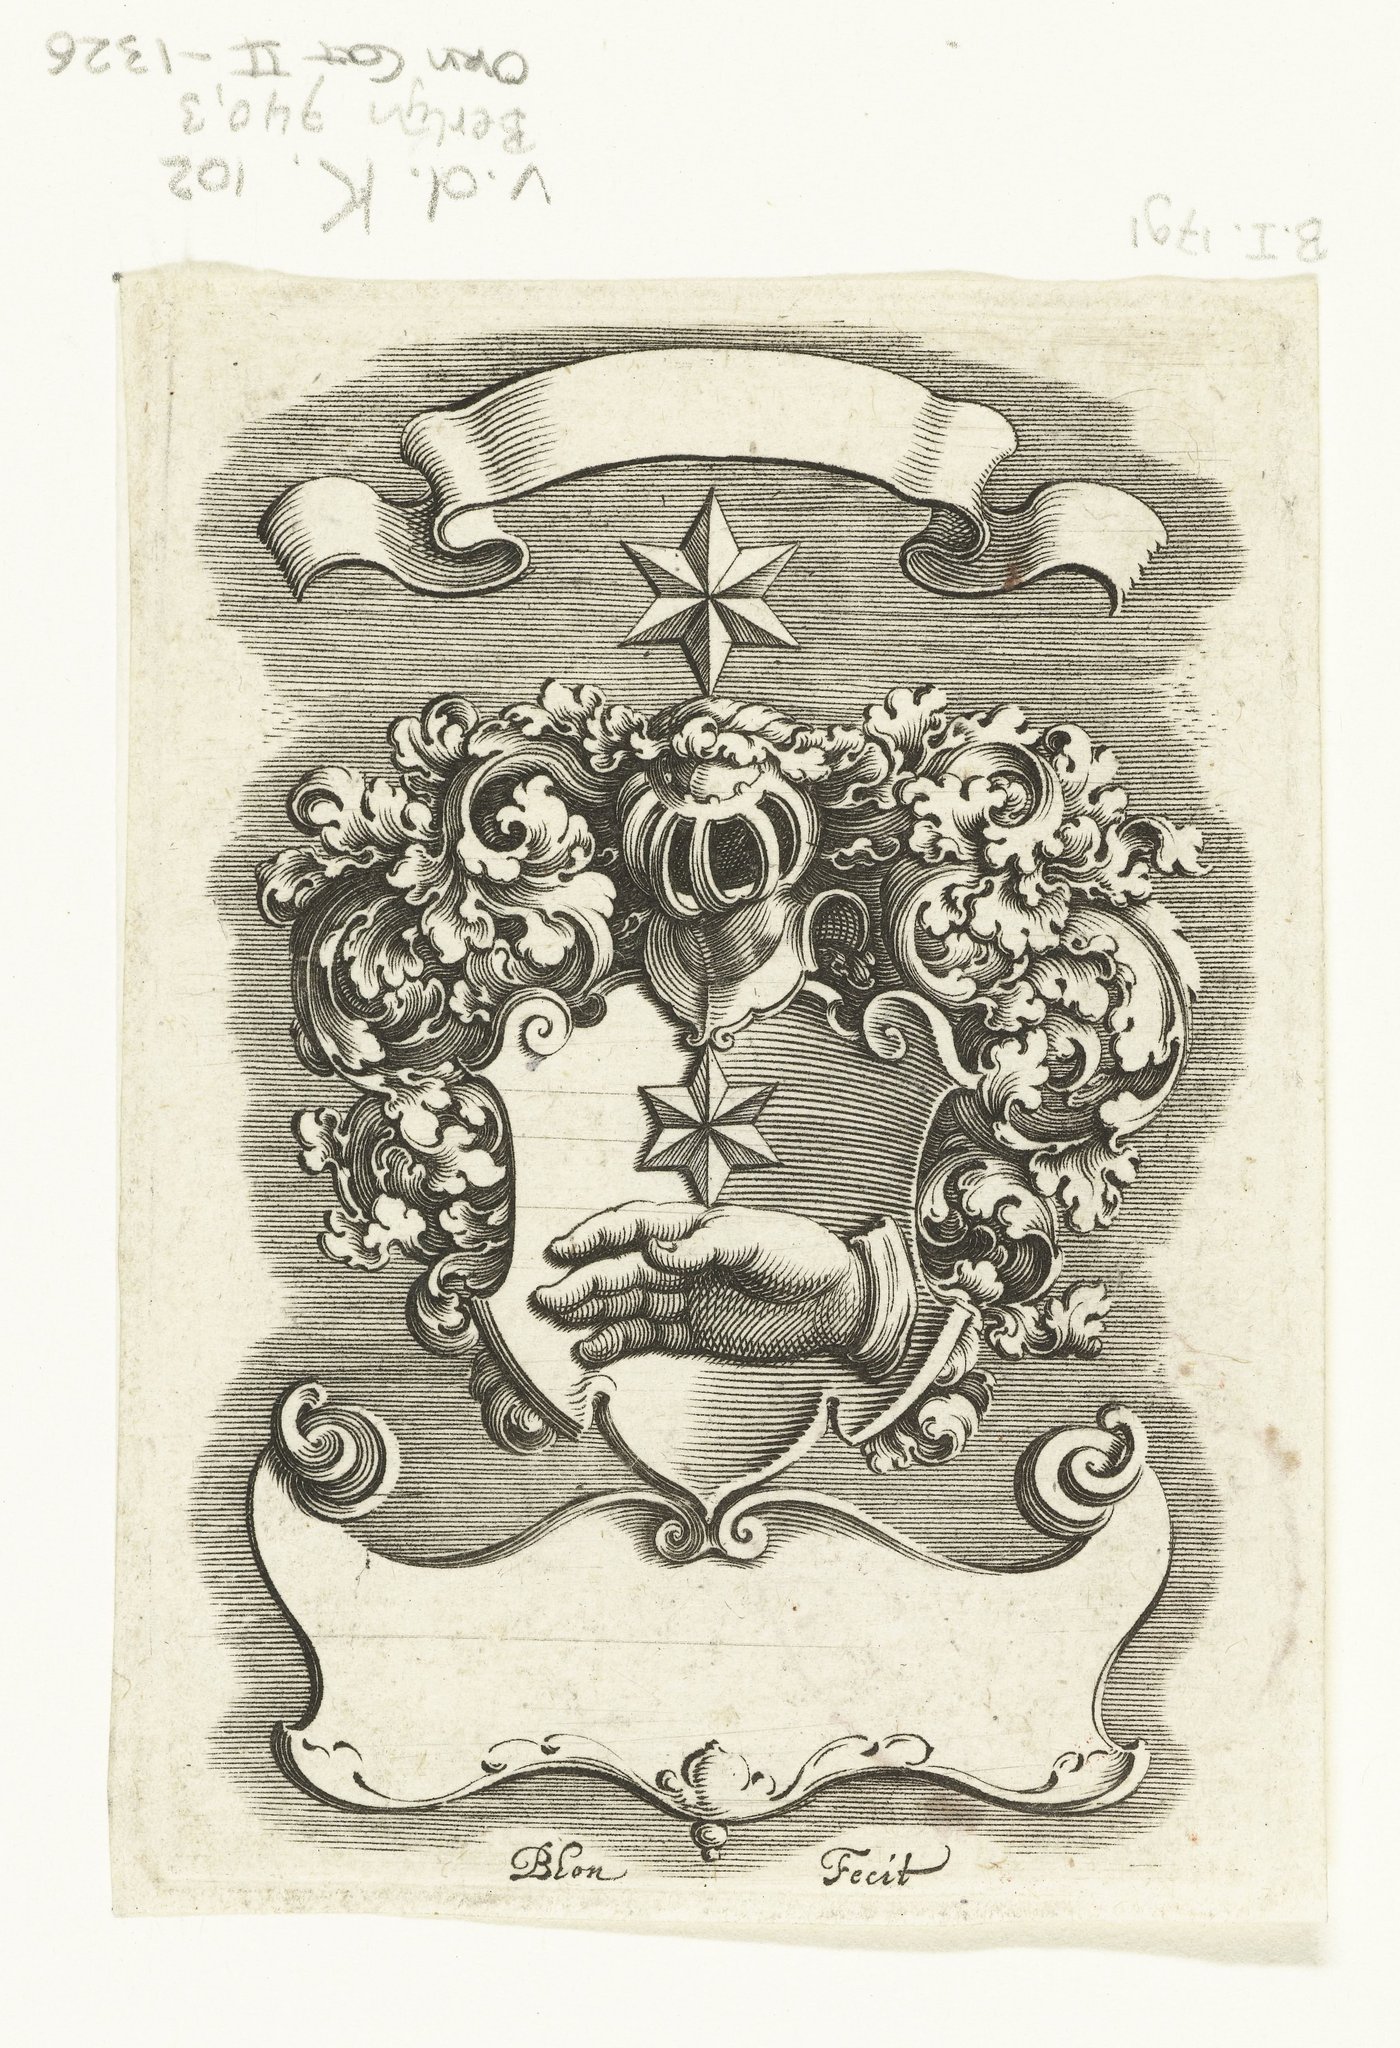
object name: ornament print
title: Wapenschilden met lege banderollen en lege cartouches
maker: michiel le blon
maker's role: print maker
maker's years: 1587-1656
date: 1611-1625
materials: paper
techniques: engraving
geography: amsterdam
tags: armorial bearing, heraldry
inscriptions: collector's mark: Lugt 240